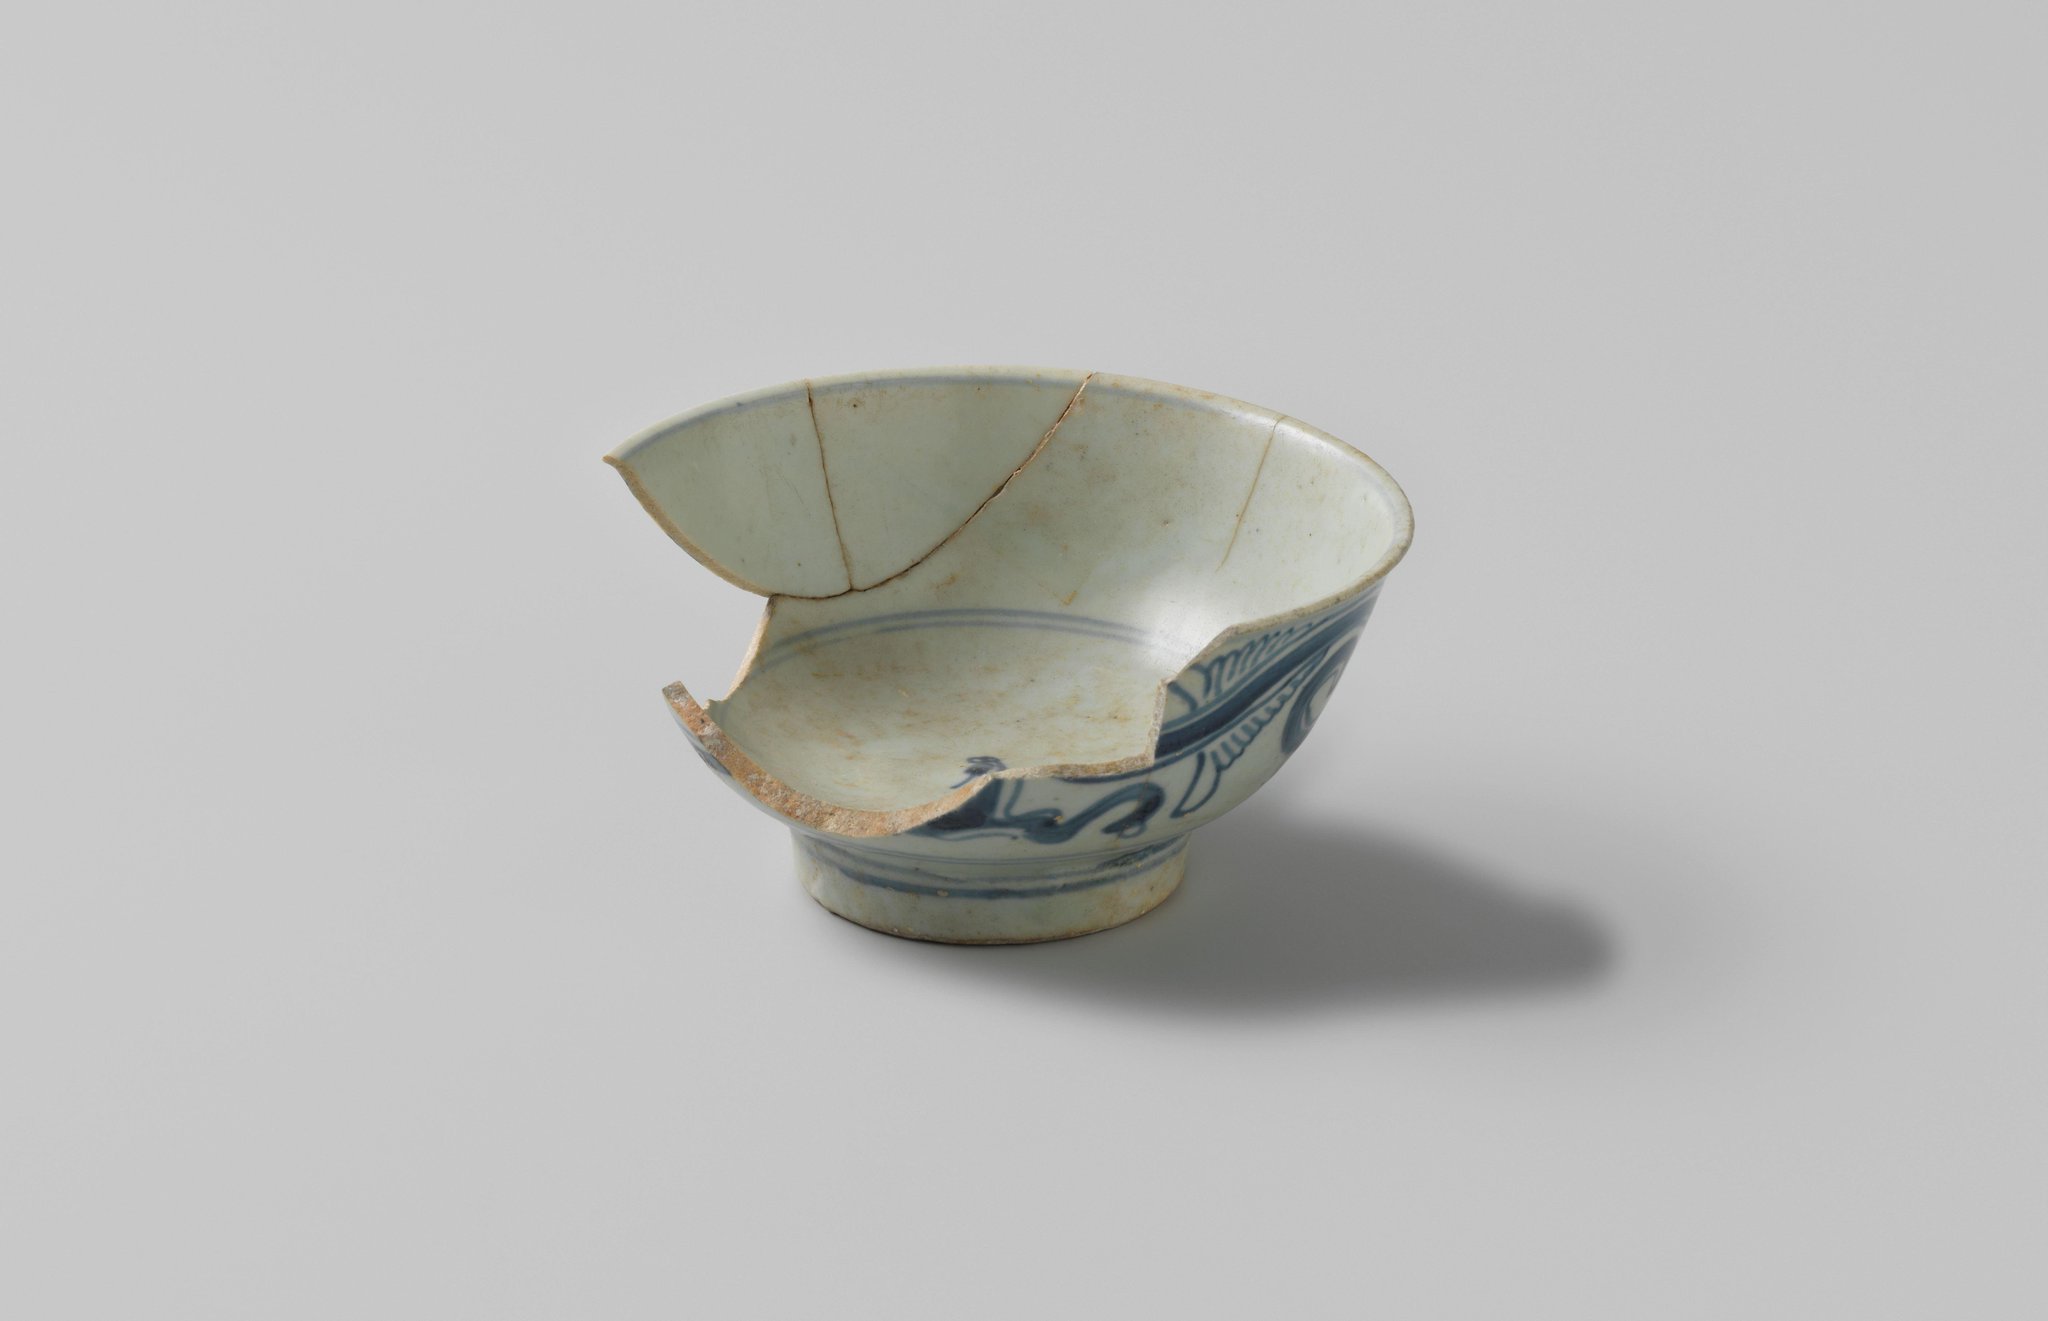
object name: sherd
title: Fragment van een kom uit V.O.C.-schip de 'Witte Leeuw'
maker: Anonymous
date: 1613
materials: porcelain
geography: jingdezhen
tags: verenigde oostindische compagnie, sint-helena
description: A bowl. The underglaze is very light blue. The footring is burnt red, is high and faceted. The bottom is glazed and has a mark in underglaze blue: probably ru (ju) i.e. jade, and zi, i.e. precious thing. In the centre an unclear motive surrounded by a double band. On the outside a spiral motive.